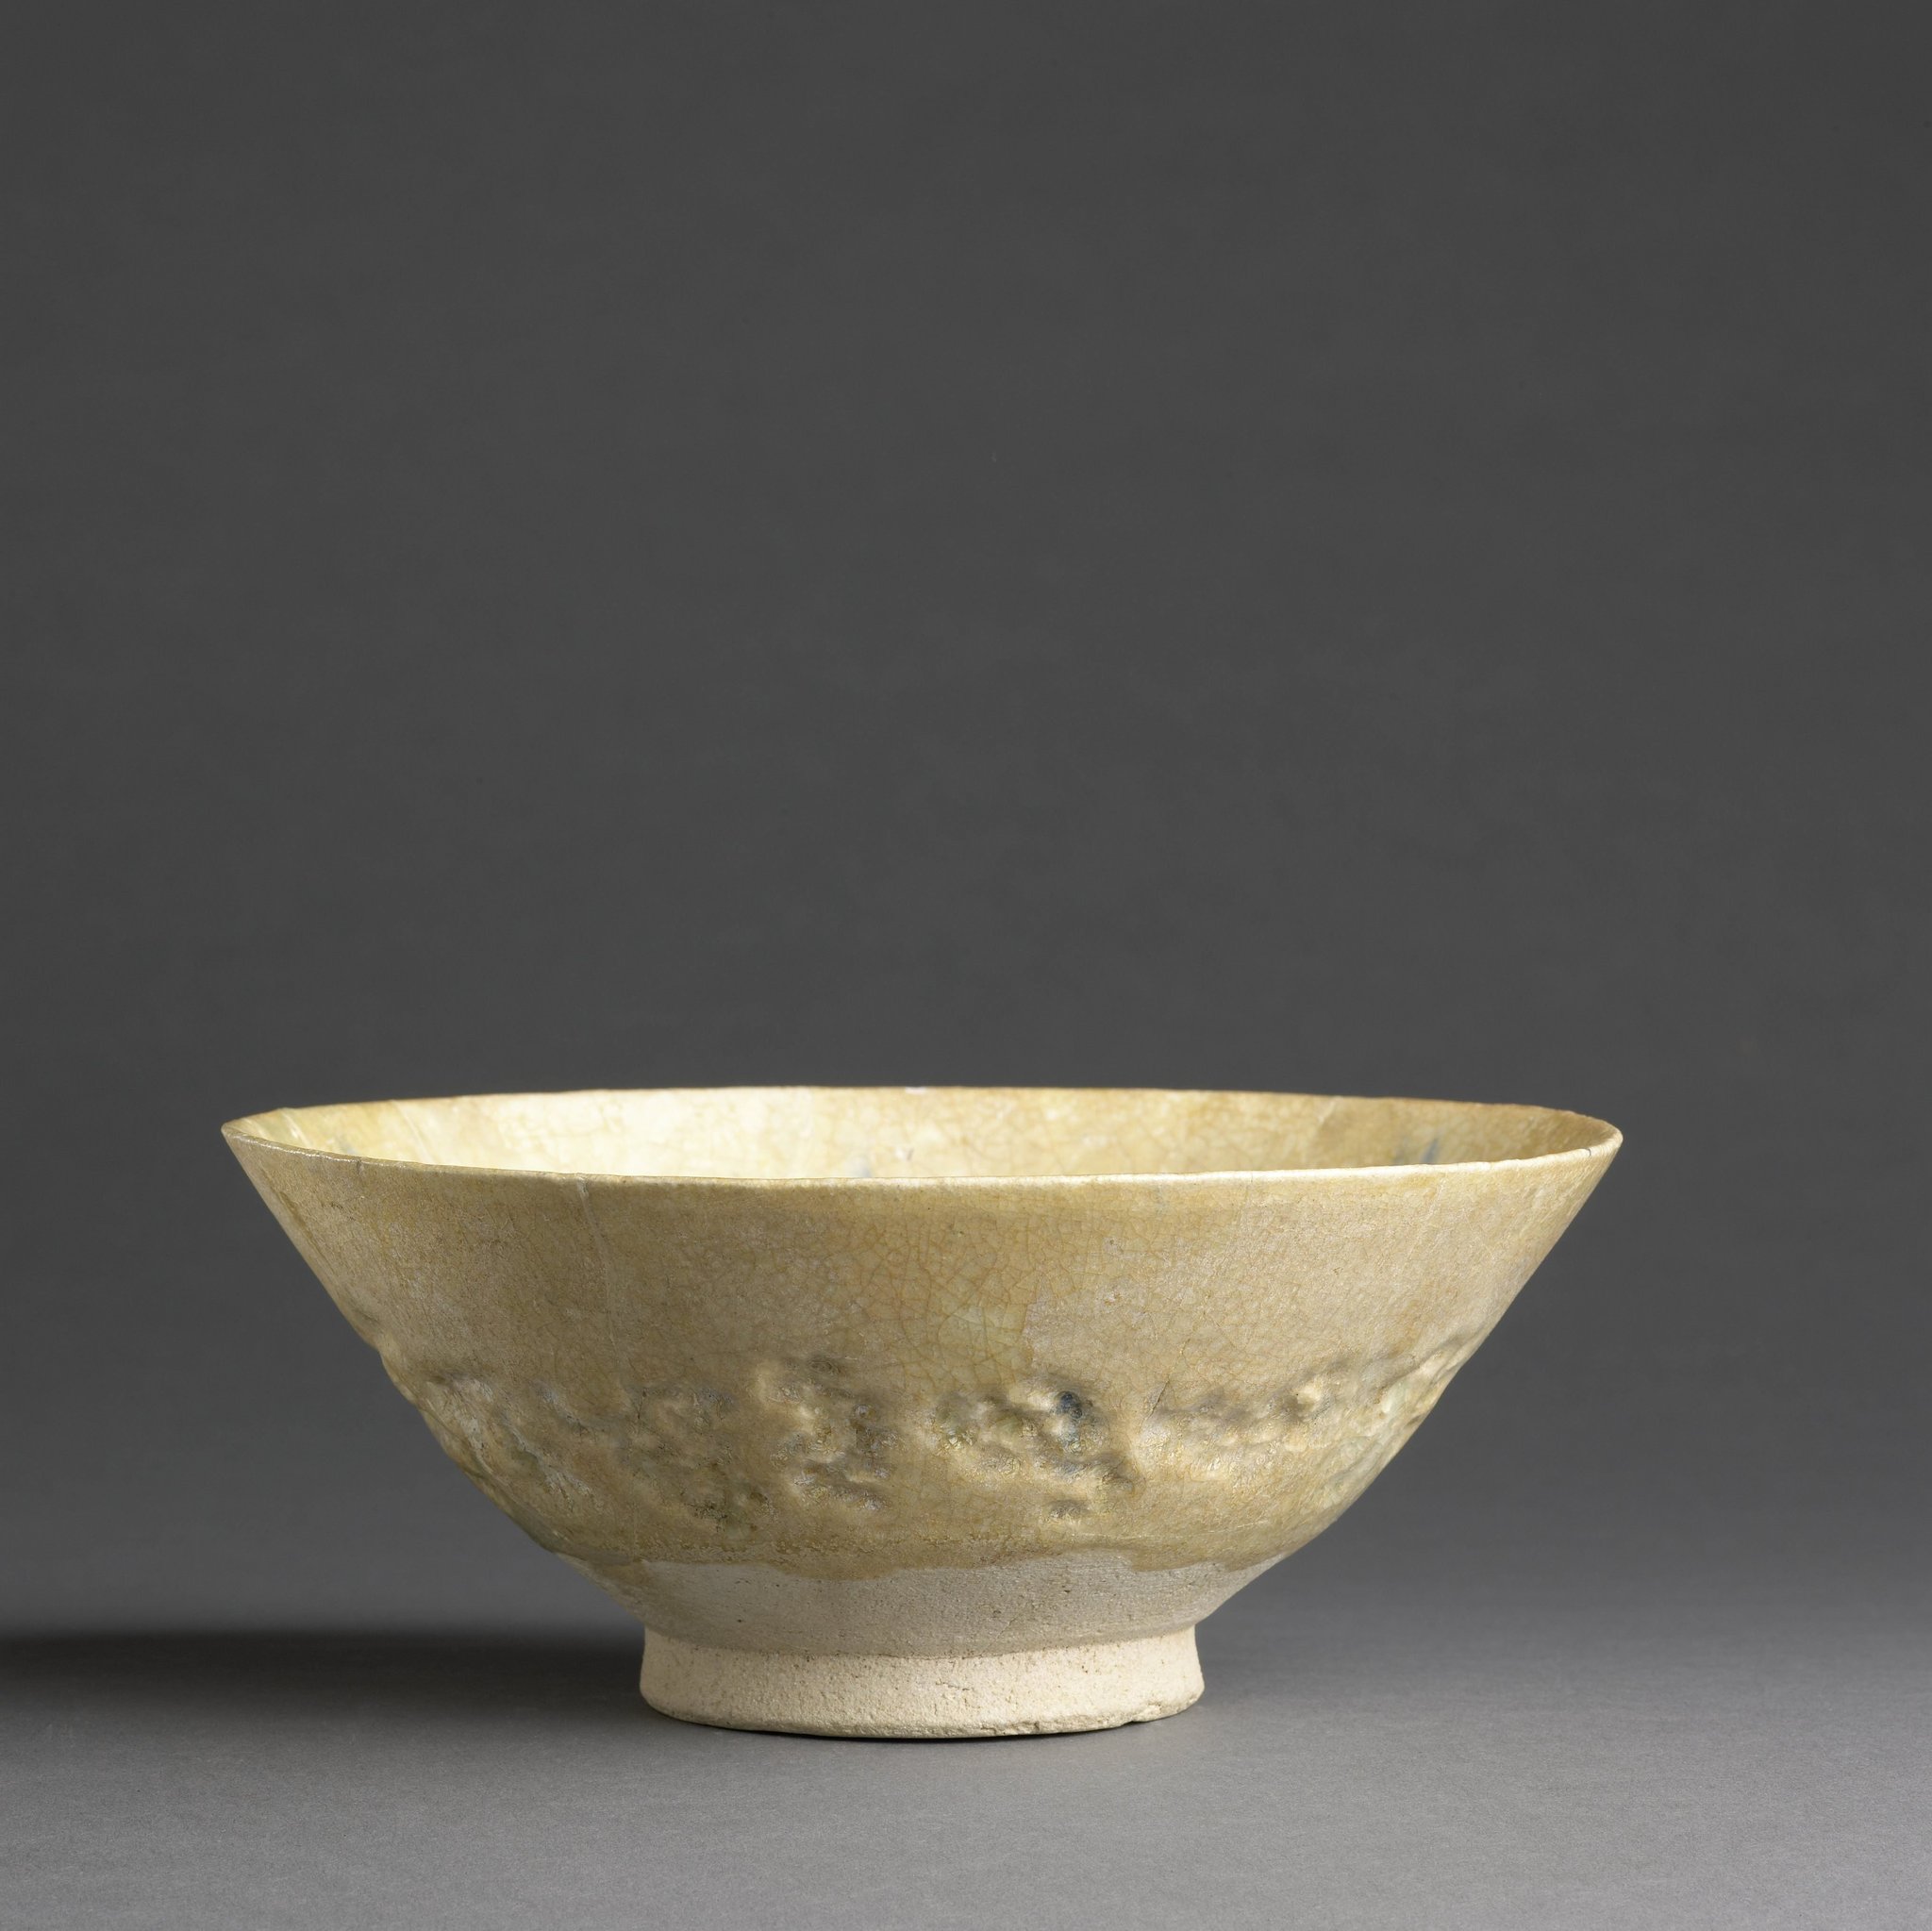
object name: bowl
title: Bowl with six blue lines and perforations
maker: Anonymous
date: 1175-1224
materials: cobalt, earthenware, glaze, paint, quartz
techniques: engraving, firing, perforating, turning, vitrification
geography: iran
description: Bowl. Iran, 1175 - 1225. Stone paste. Given by Prof. Dr J.A. Oosterbaan and Mrs Oosterbaan-Lugt.